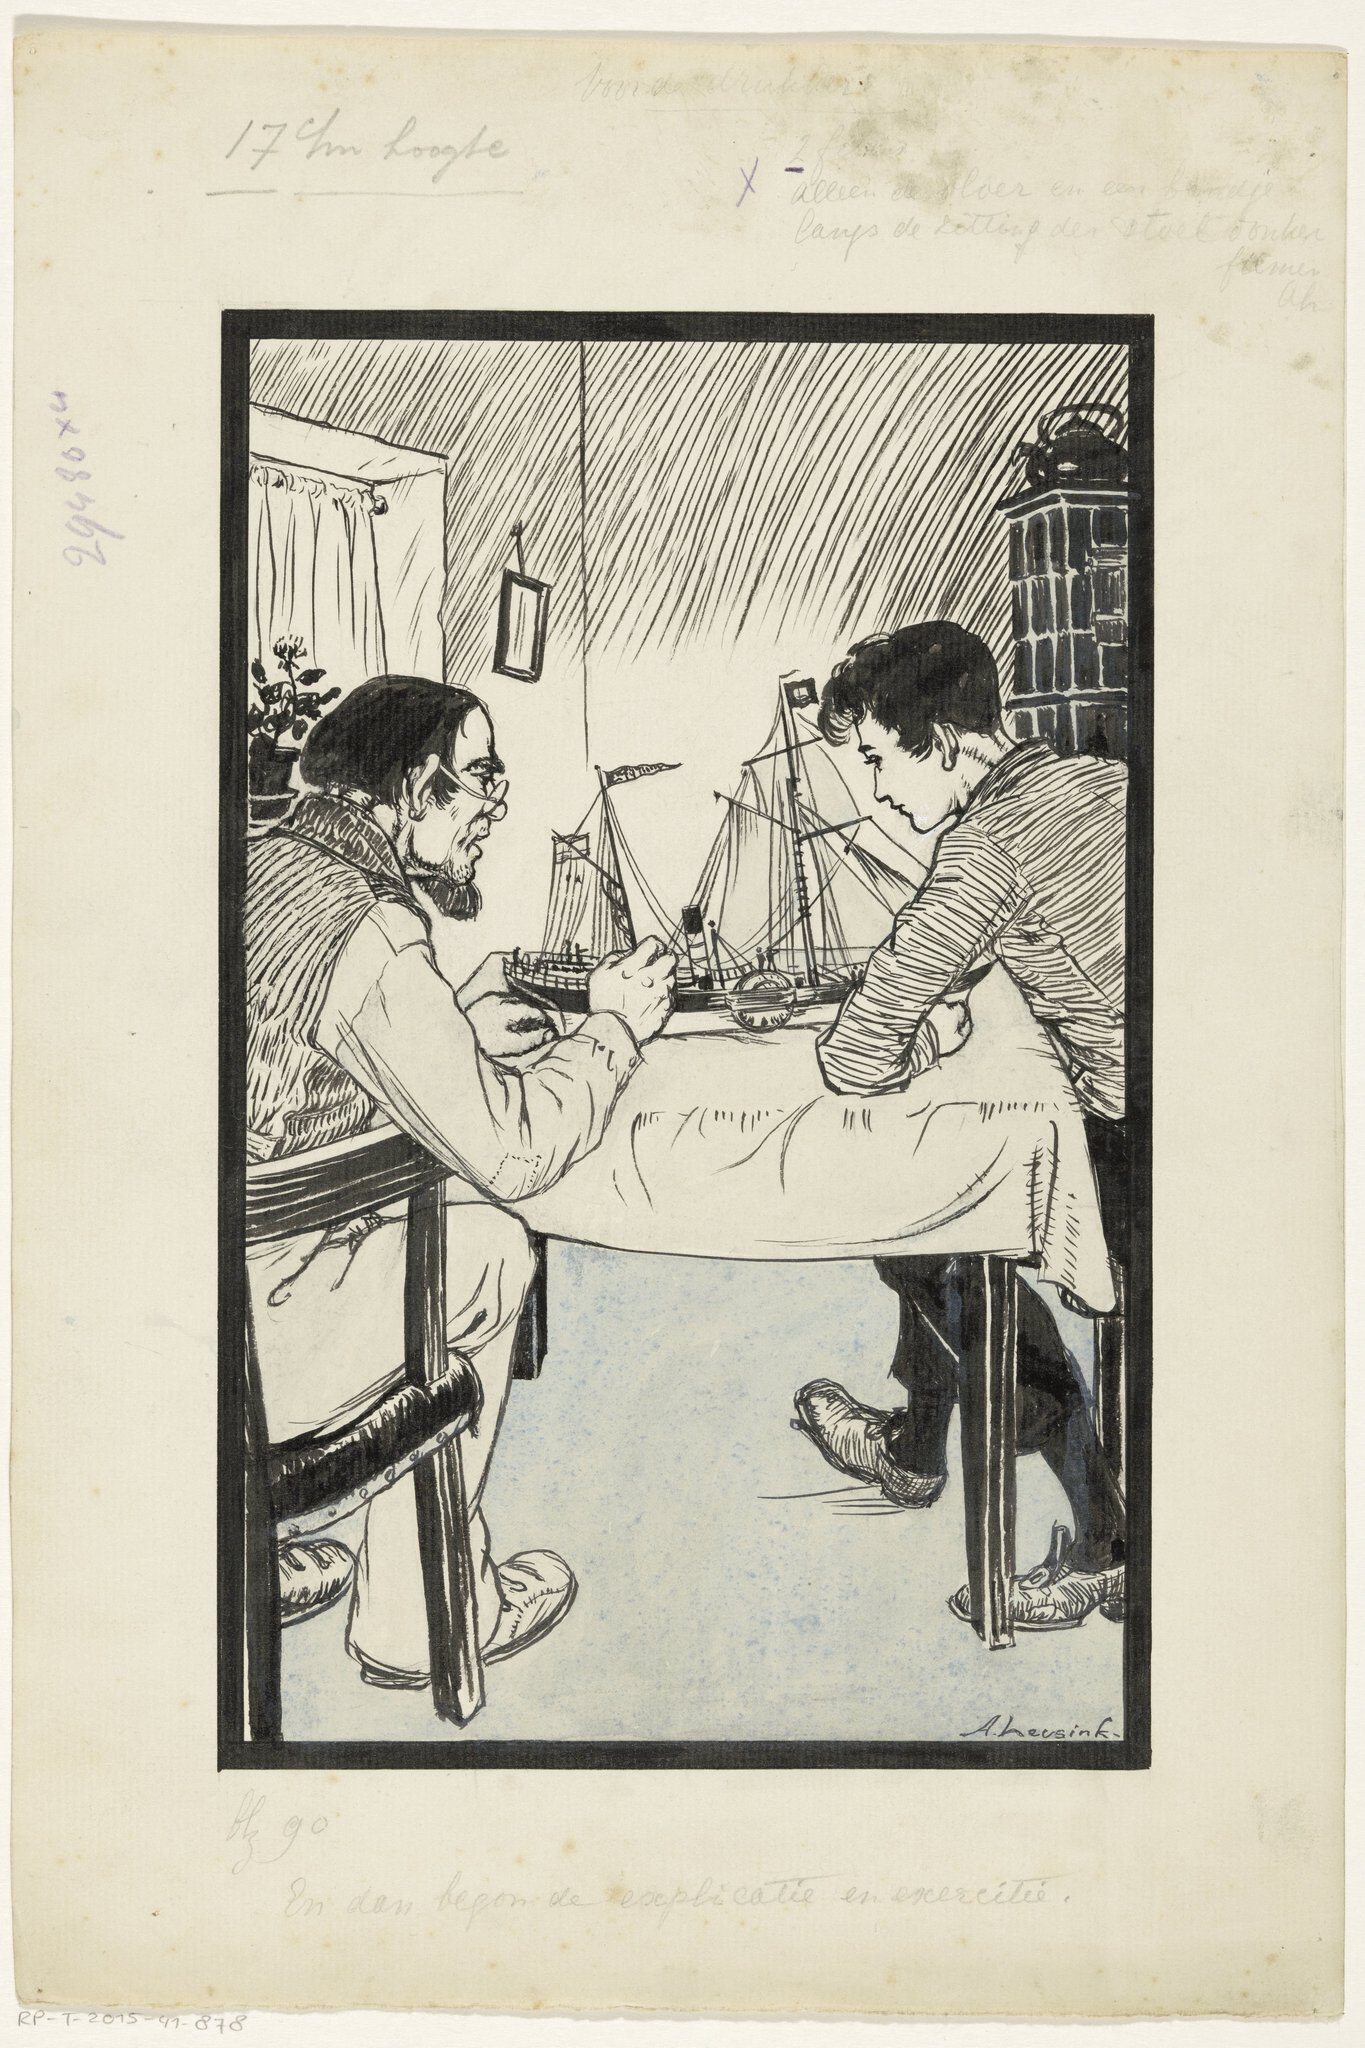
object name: drawing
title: Willem en zijn vader werken aan een scheepsmodel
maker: anny leusink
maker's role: draughtsman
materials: paint, ink, paper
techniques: brush, pen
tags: interior of the house, father and son(s) (family group), ship-model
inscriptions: annotation: ‘blz 90/ En dan begon de explicatie en exercitie.’, :, collector's mark: Lugt 2228, signature: ‘A. Leusink.’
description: Willem en zijn vader zitten in een woonkamer aan tafel en buigen zich over een scheepsmodel.